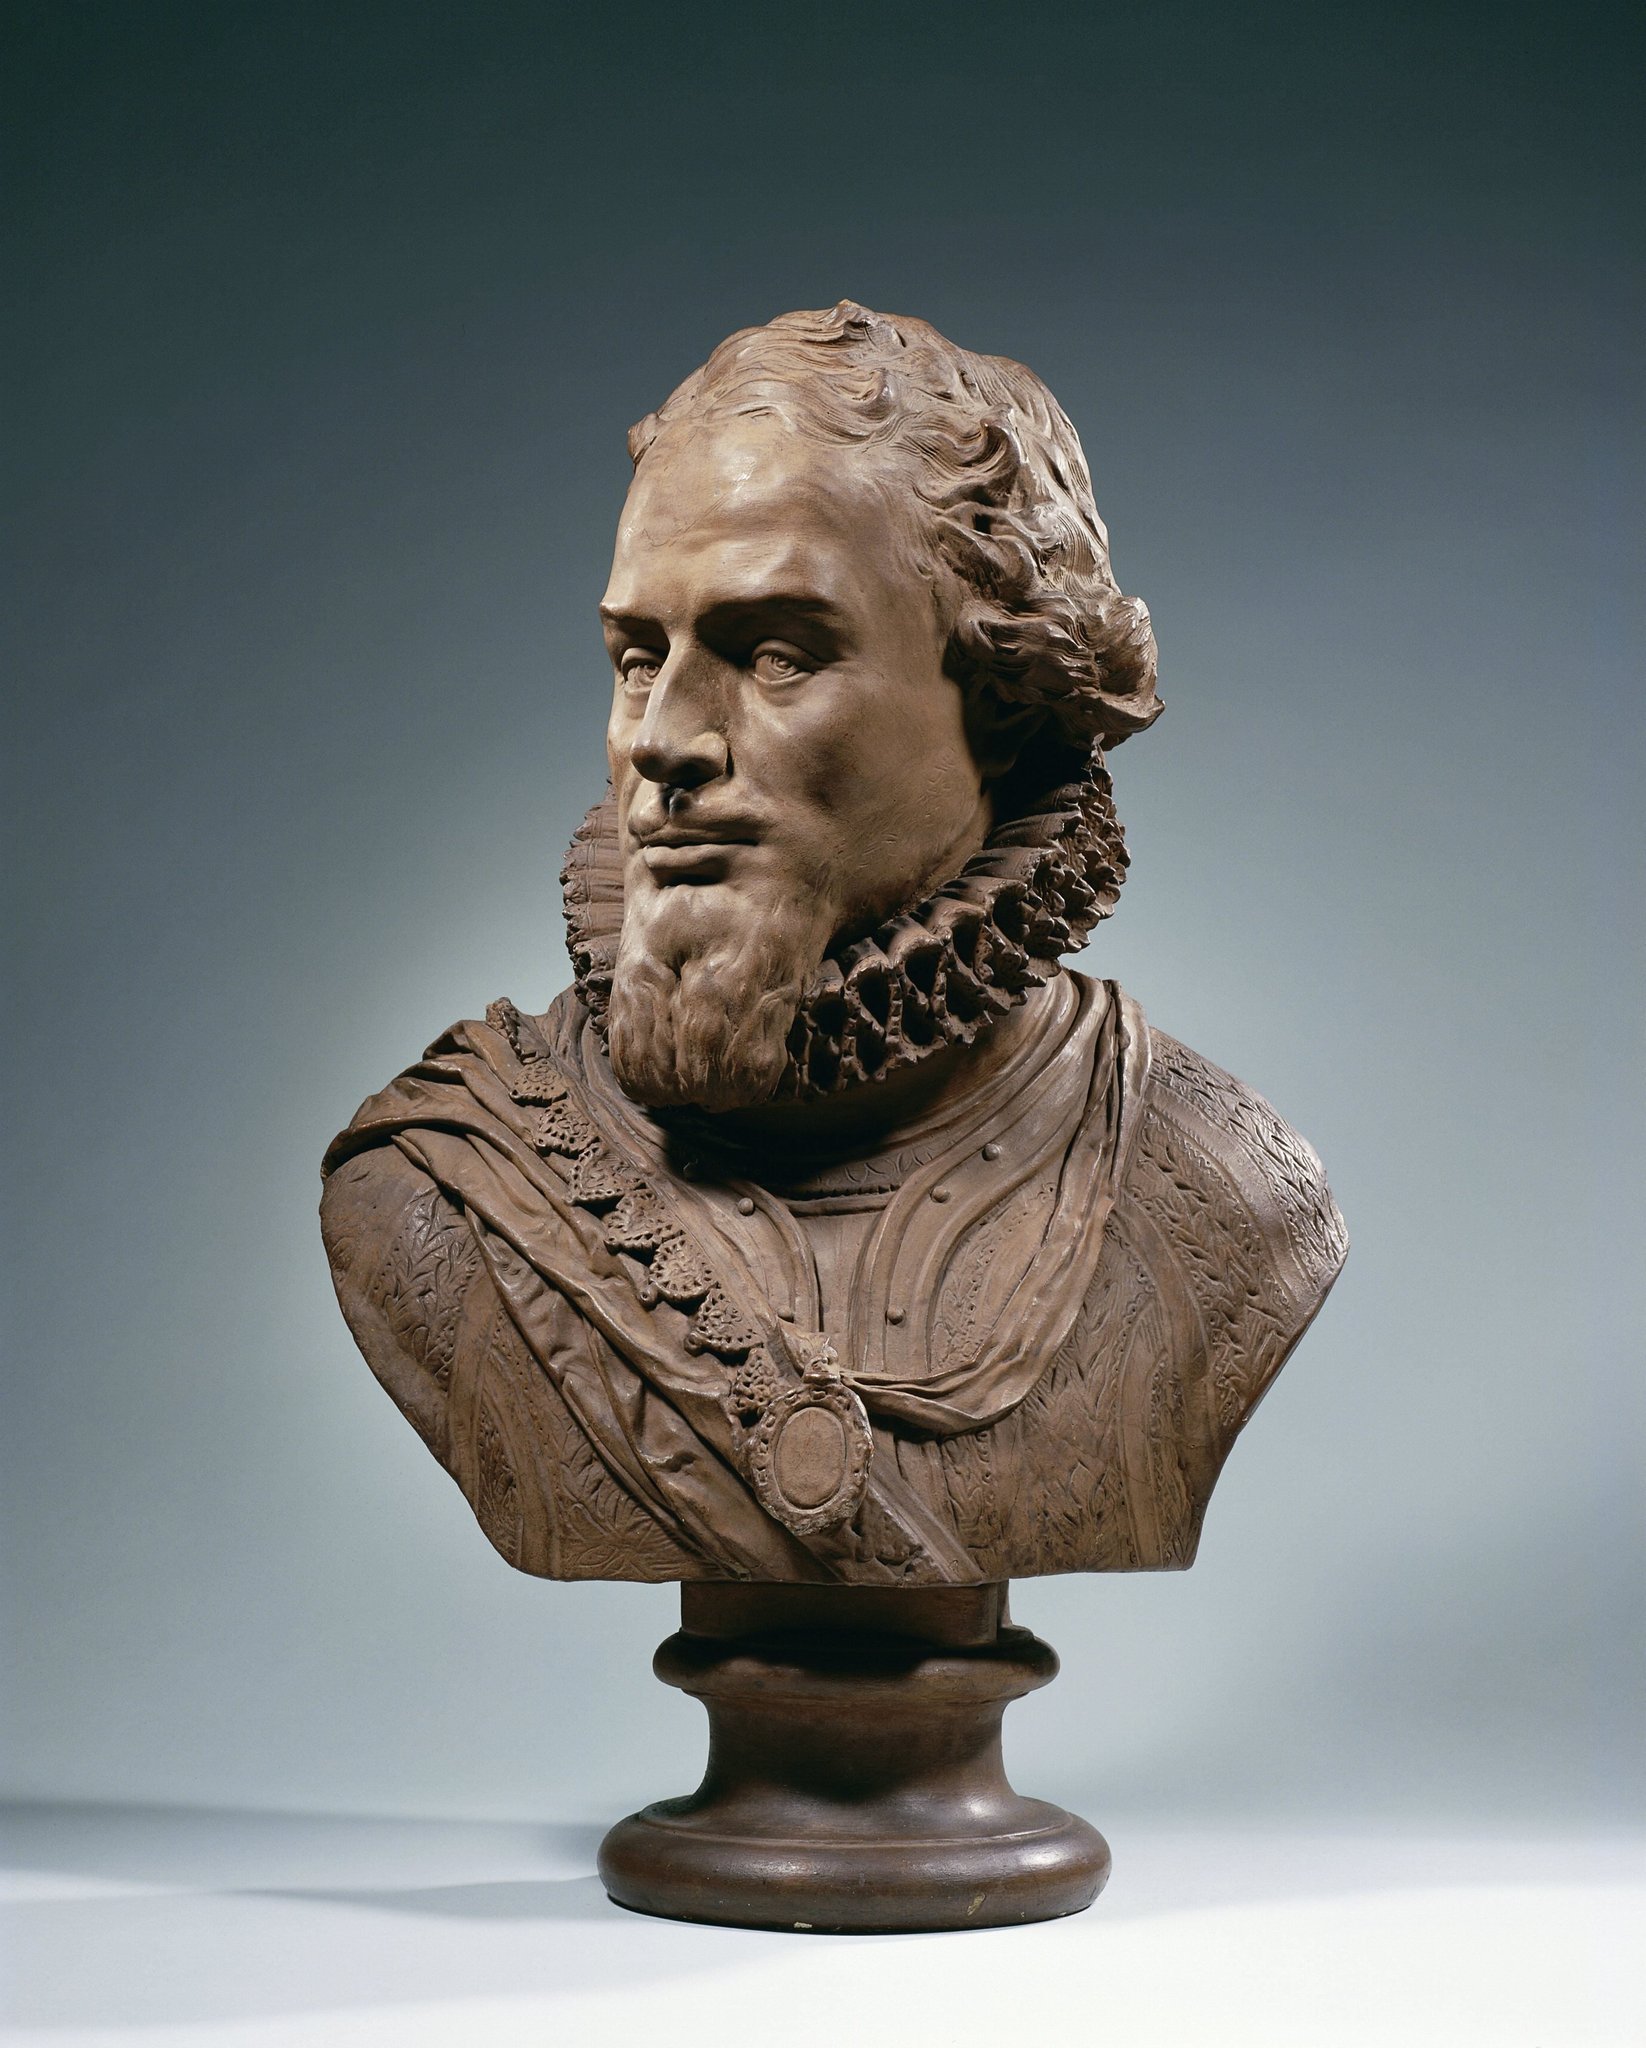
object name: sculpture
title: Maurice, Prince of Orange (1567-1625)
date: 1692-1697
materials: terracotta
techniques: modeling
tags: maurice (prince of orange)